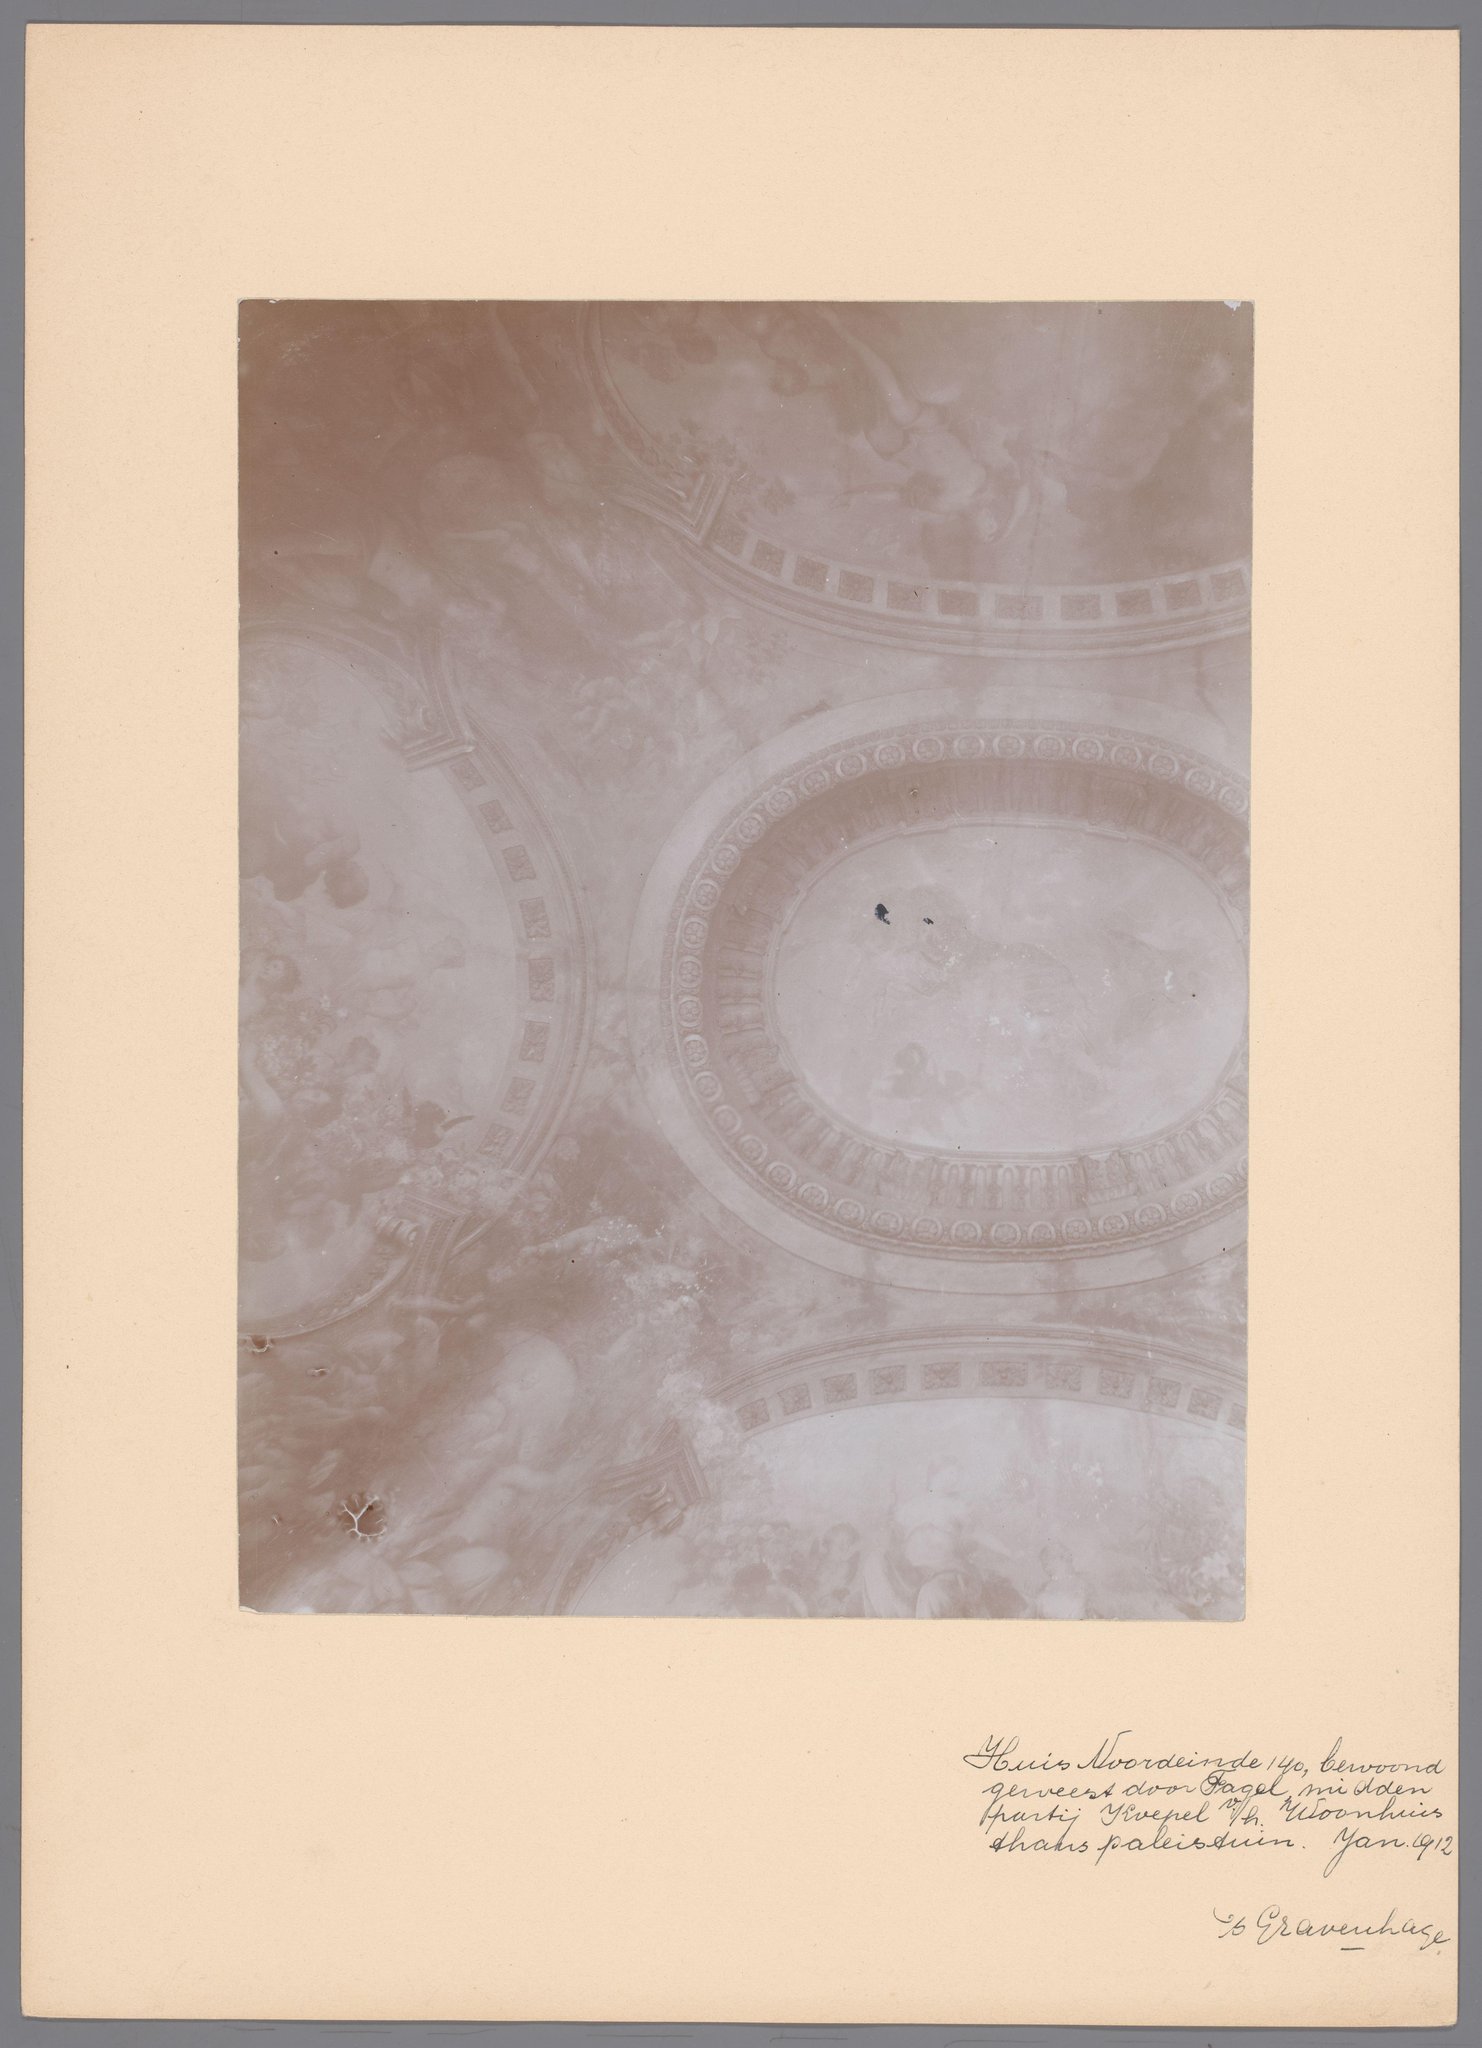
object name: photograph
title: Geschilderd plafond in Noordeinde 140 te Den Haag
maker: anoniem (monumentenzorg)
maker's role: fotograaf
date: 1912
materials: cardboard, photographic support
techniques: collodion silver print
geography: noordeinde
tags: (decorated) ceiling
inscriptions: collector's mark: ‘R:MUS.’ Lugt 2228, annotation: ‘Ca. 1700?’, annotation: ‘Huis Noordeinde 140, bewoond geweest door Fagel, midden partij koepel v/h woonhuis thans paleistuin. Jan. 1912/ 's Gravenhage’